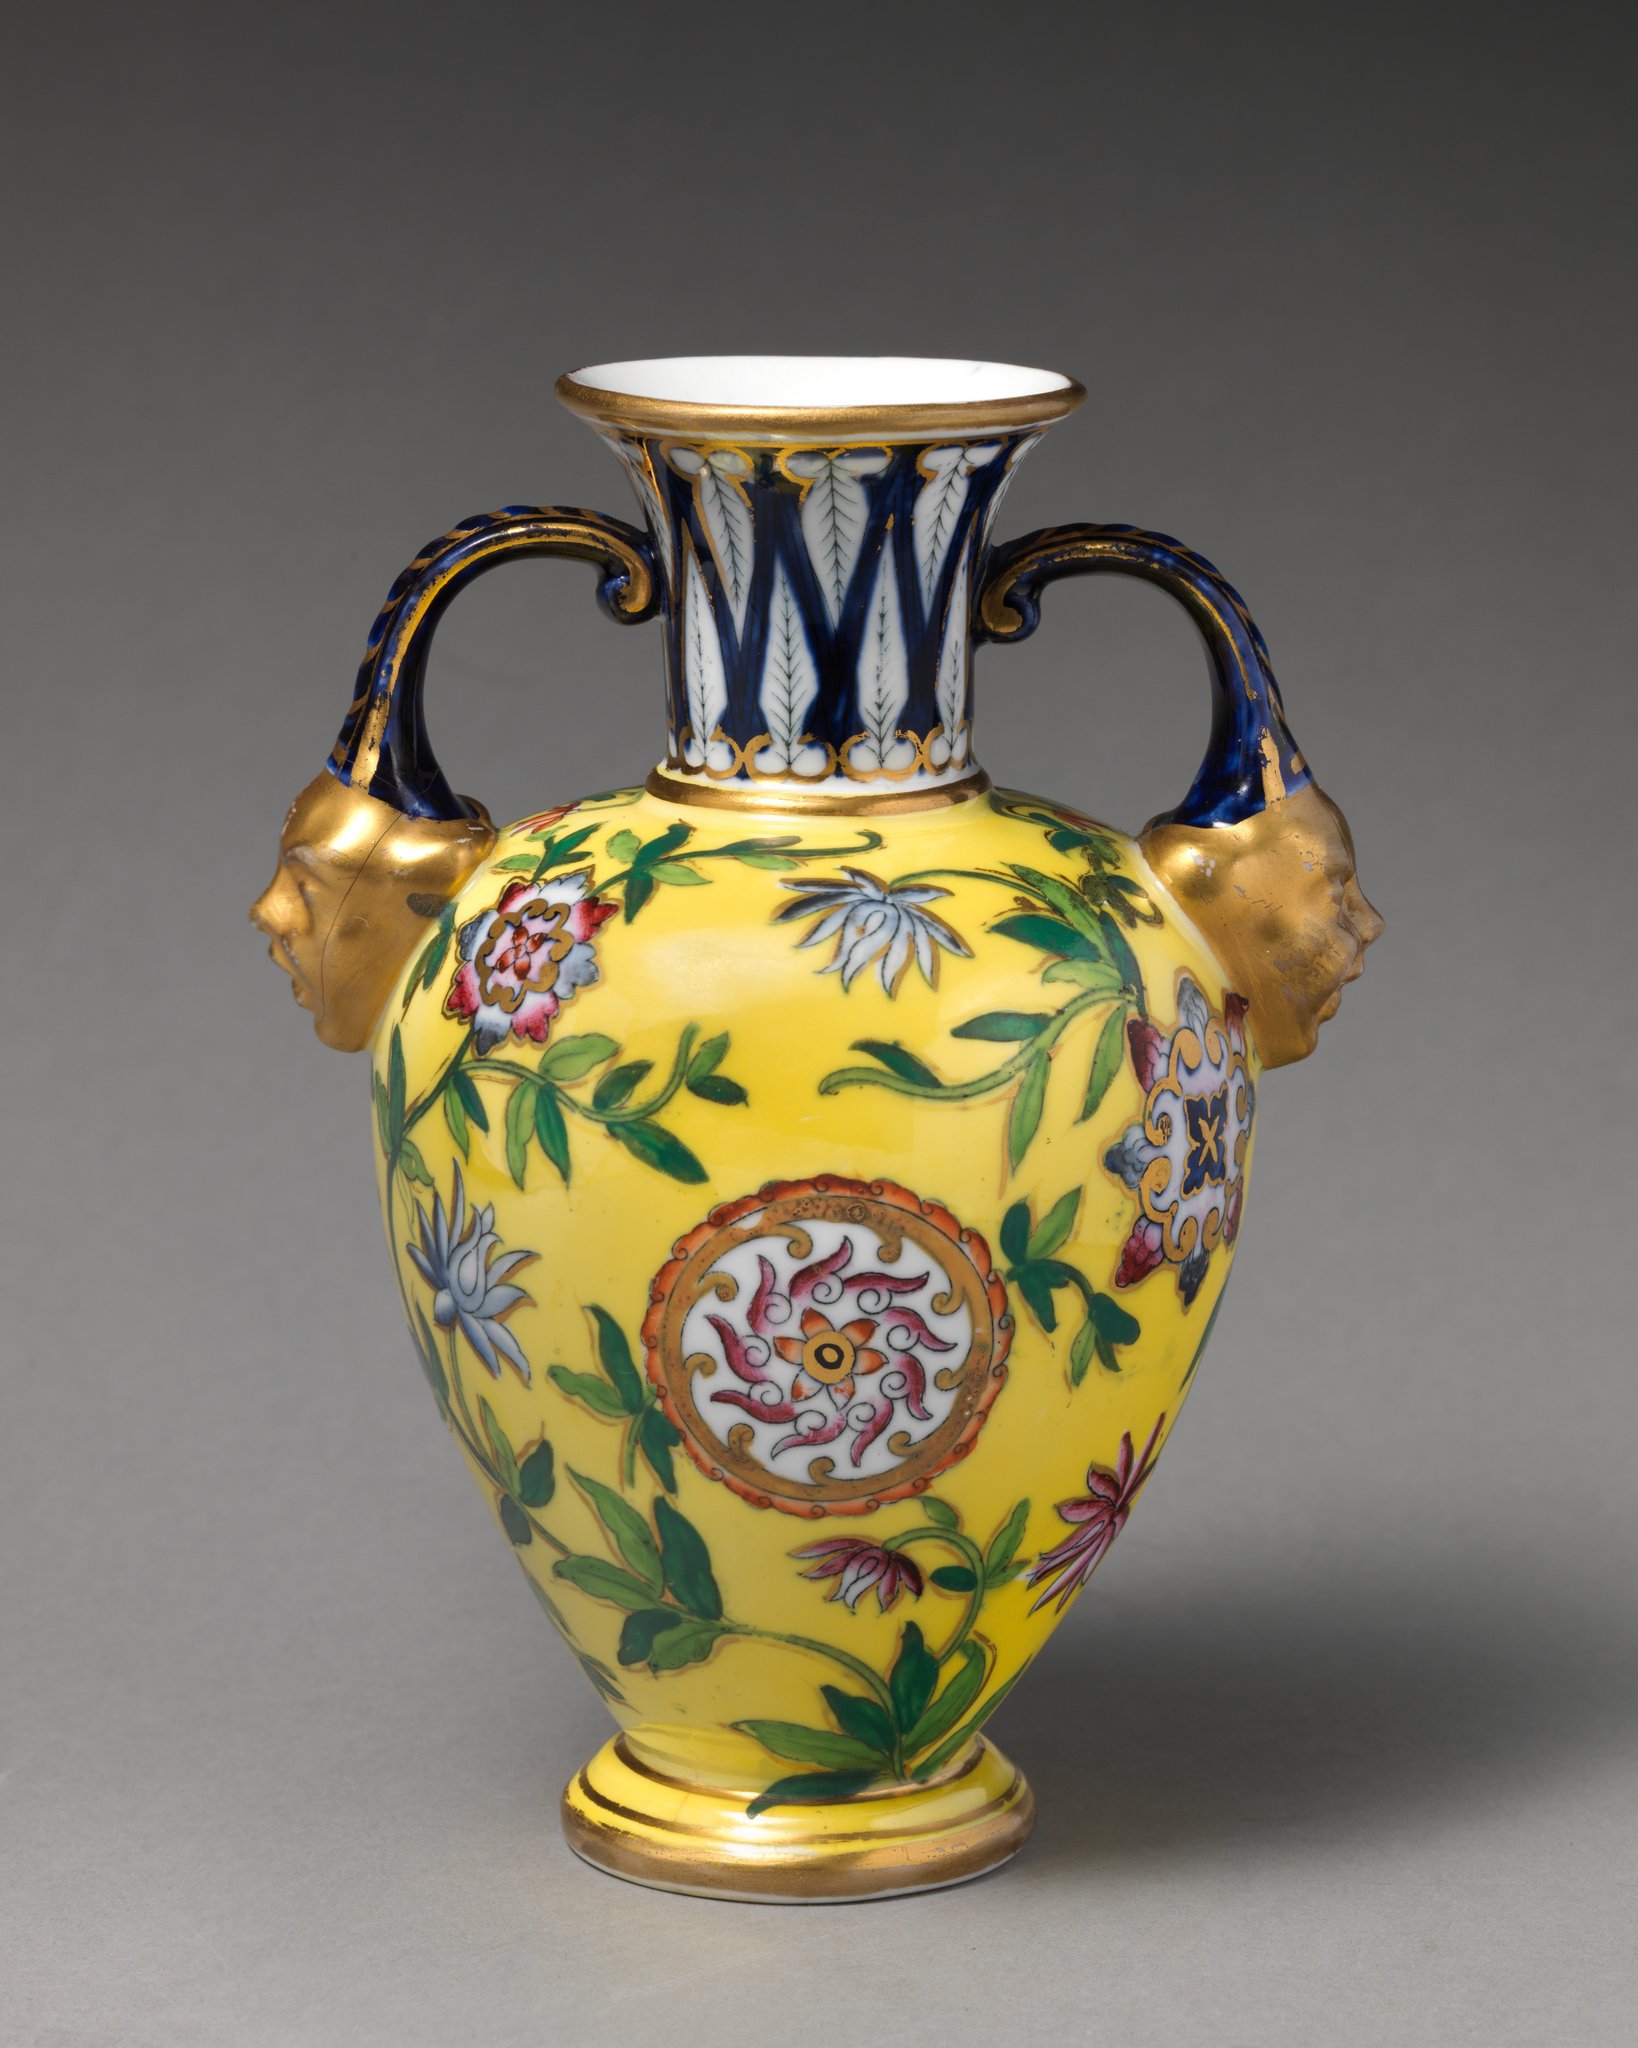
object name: vase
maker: crown derby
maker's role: maker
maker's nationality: british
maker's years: 1750-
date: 1877-1882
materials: bone china